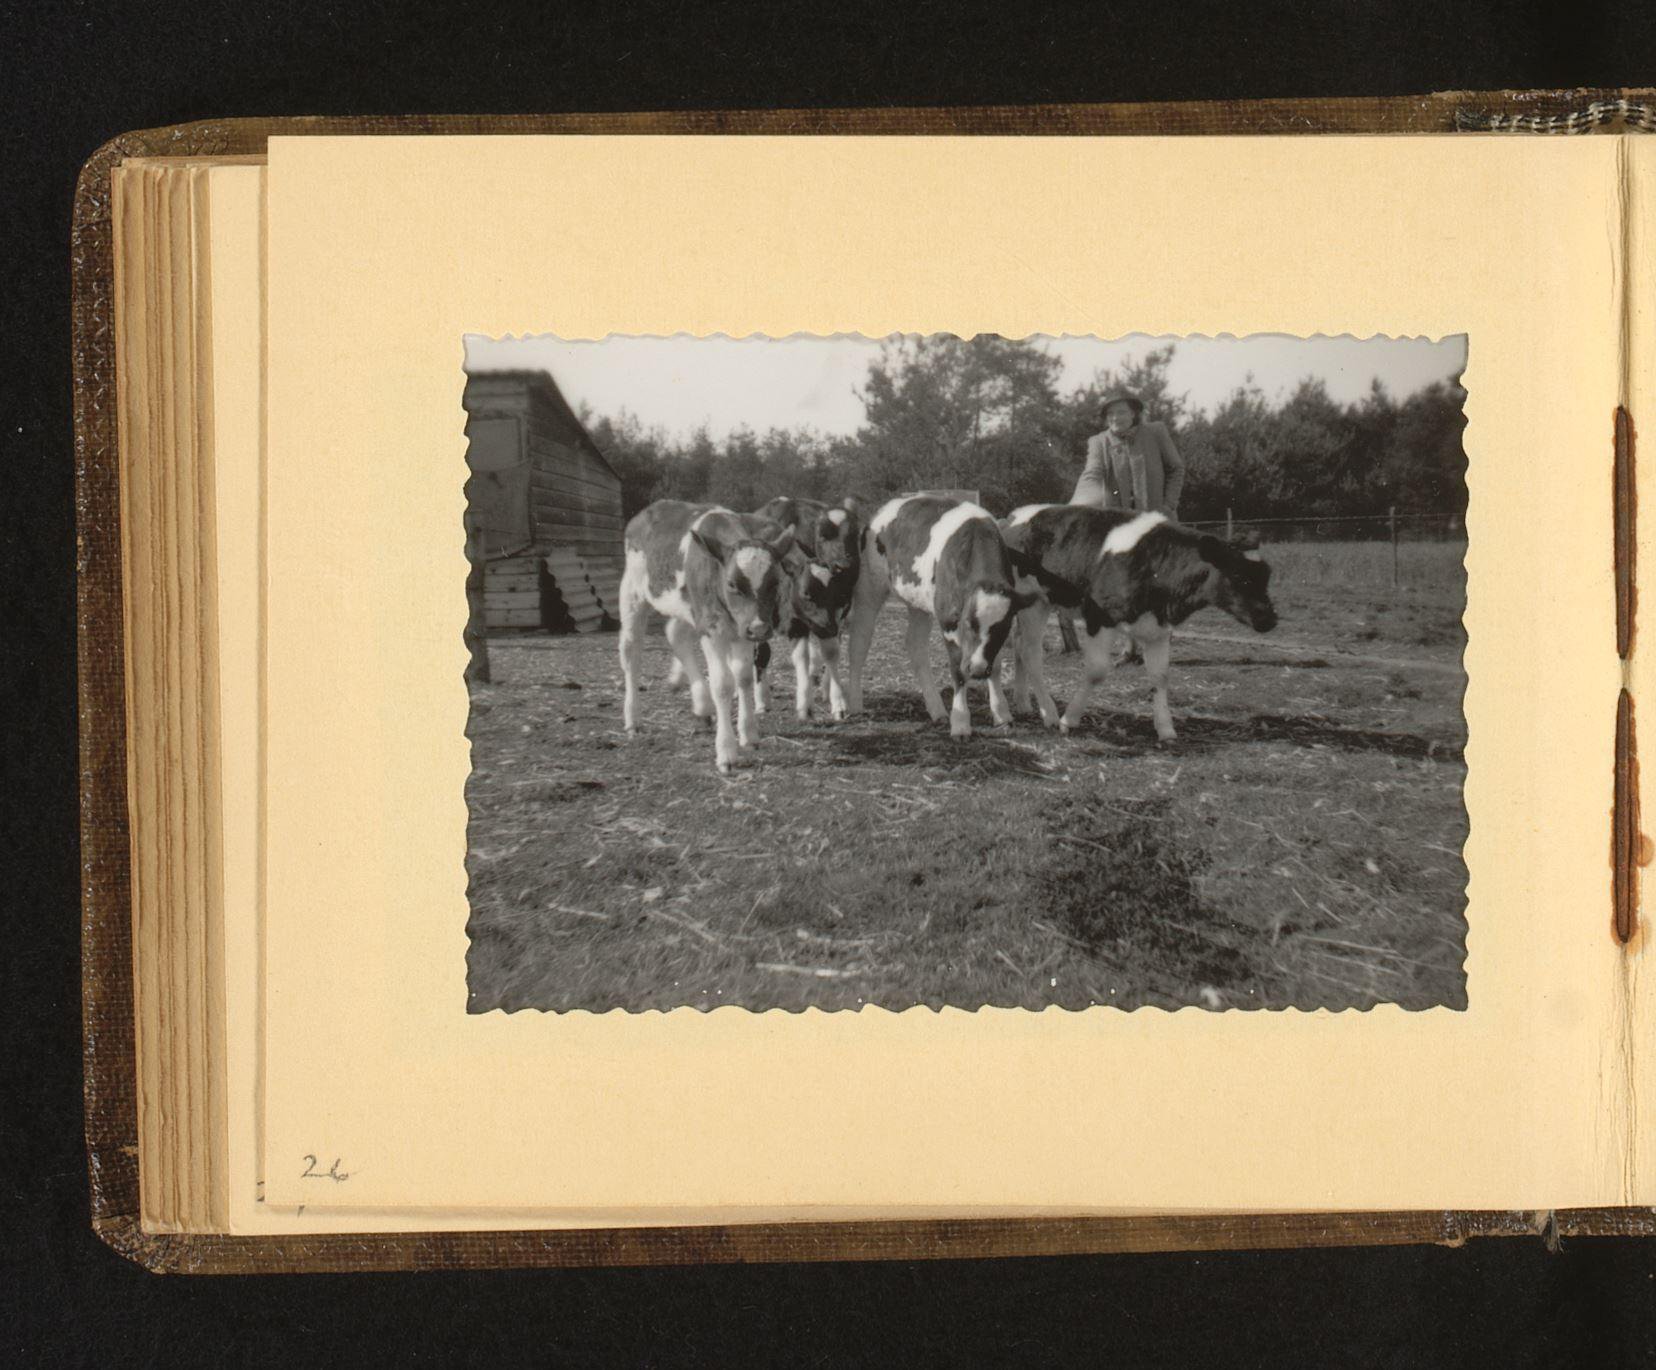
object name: photograph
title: Boer met koeien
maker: Anonymous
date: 1939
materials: cardboard, photographic support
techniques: gelatin silver print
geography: holten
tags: cow, meadow, pasture, family life at home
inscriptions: inscription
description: Albumblad met een foto van een boer staande bij een groep koeien, bij Holten. Onderdeel van het familiealbum 1938-1939.